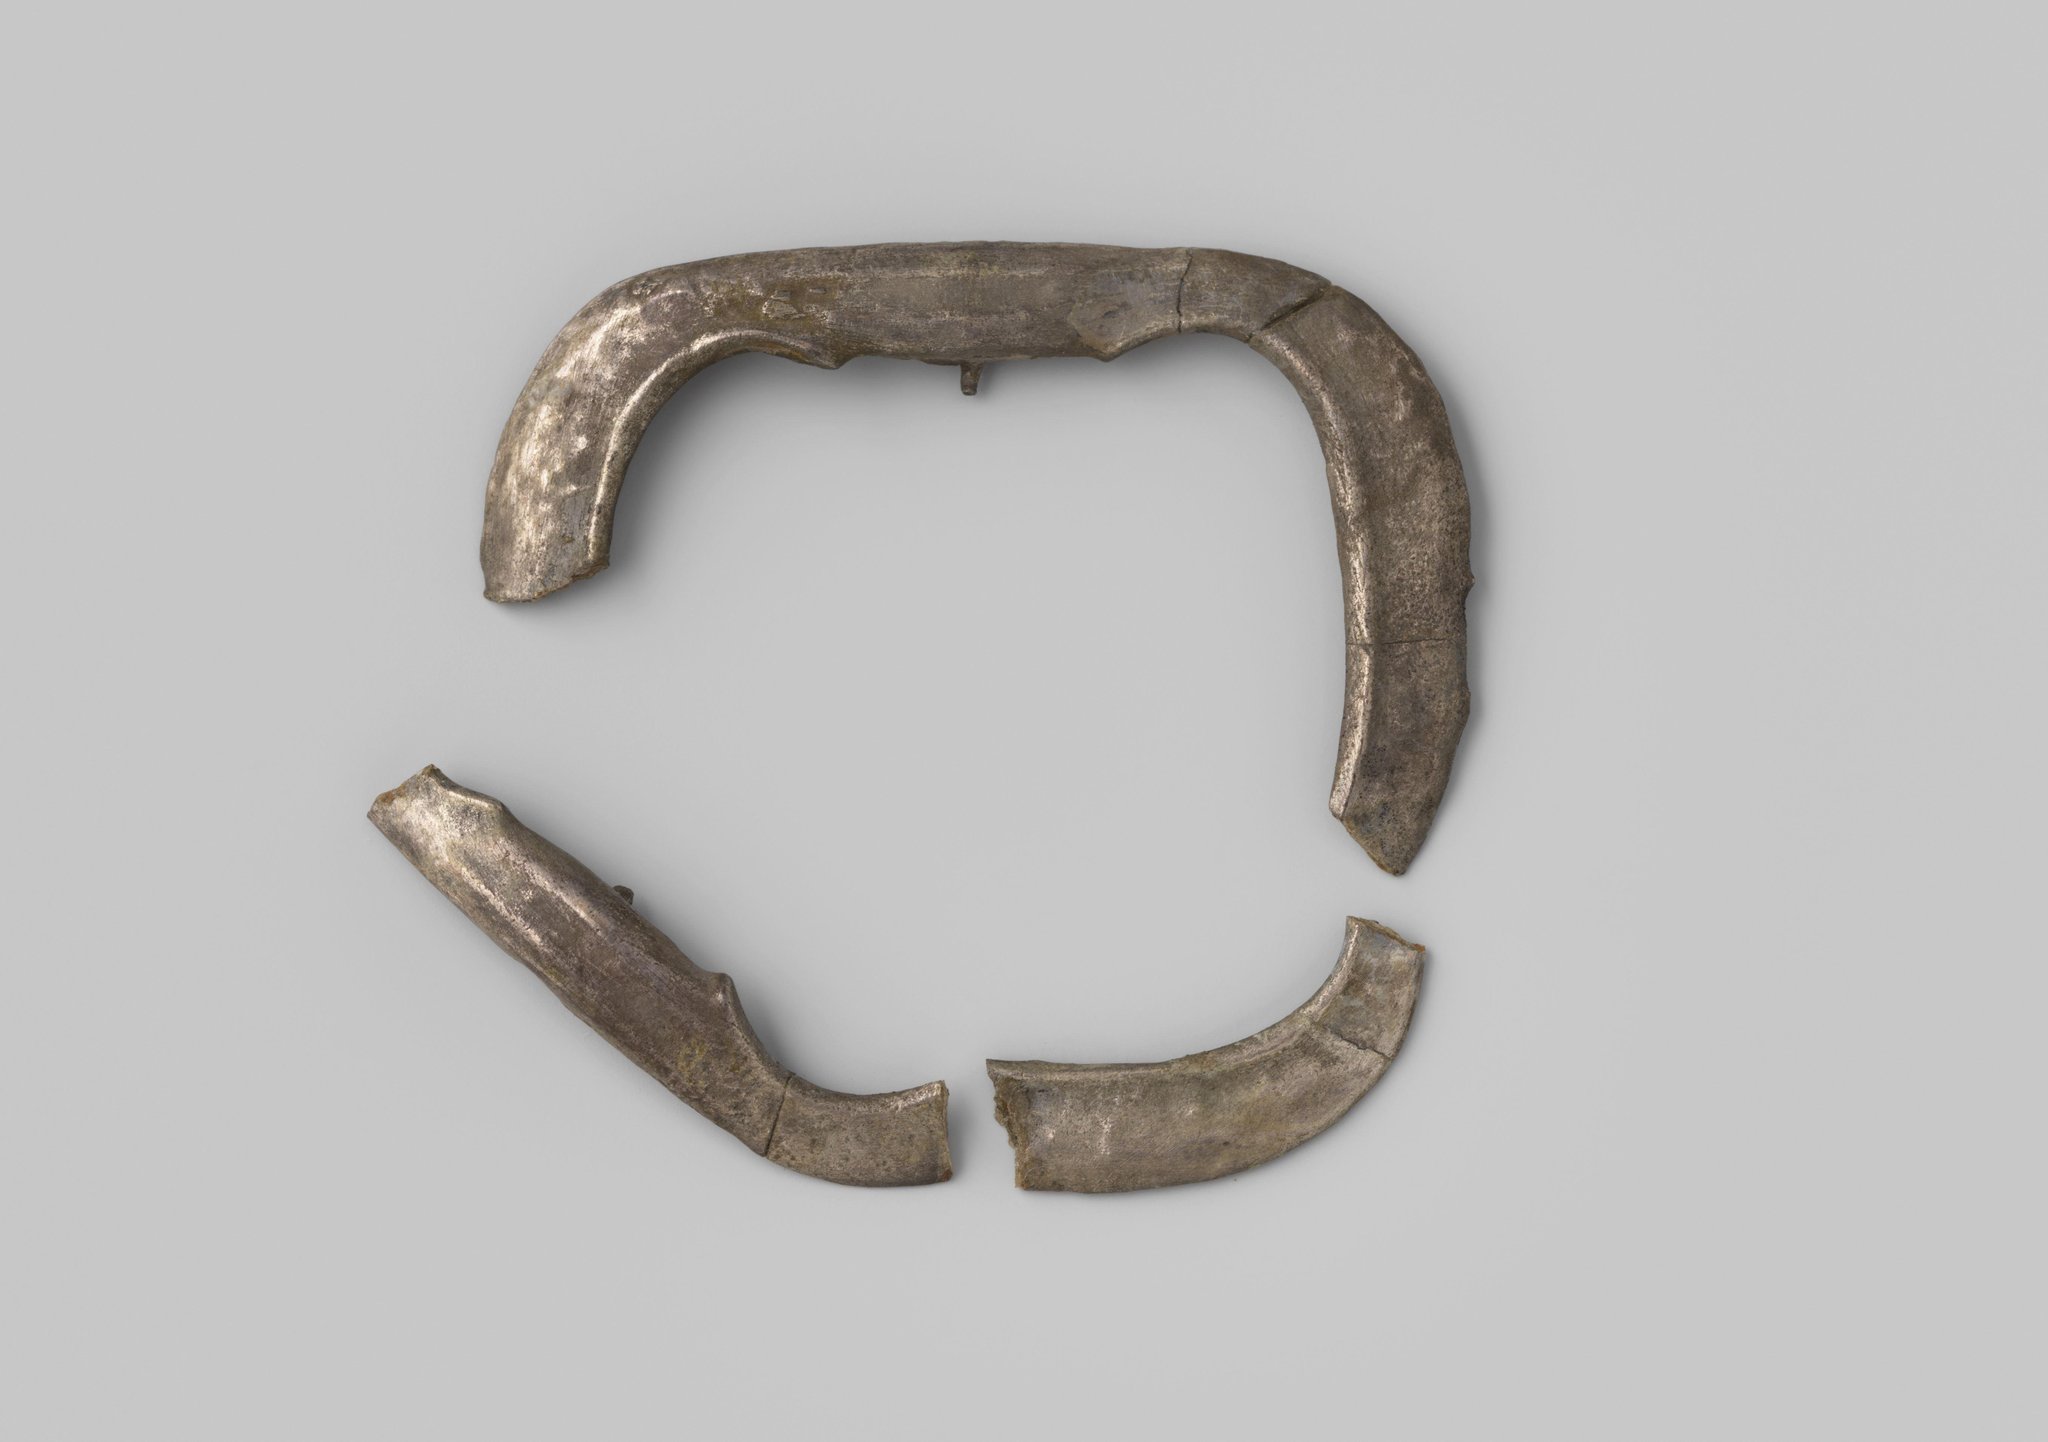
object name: shoe buckle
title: Fragmenten schoengesp uit het wrak van de Oost-Indiëvaarder Hollandia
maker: Anonymous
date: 1700-1743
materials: silver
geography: netherlands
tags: verenigde oostindische compagnie, hollandia (schip), annet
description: Buckle, chape buckle, shoe buckle; fragment ring, moulded, eroded.